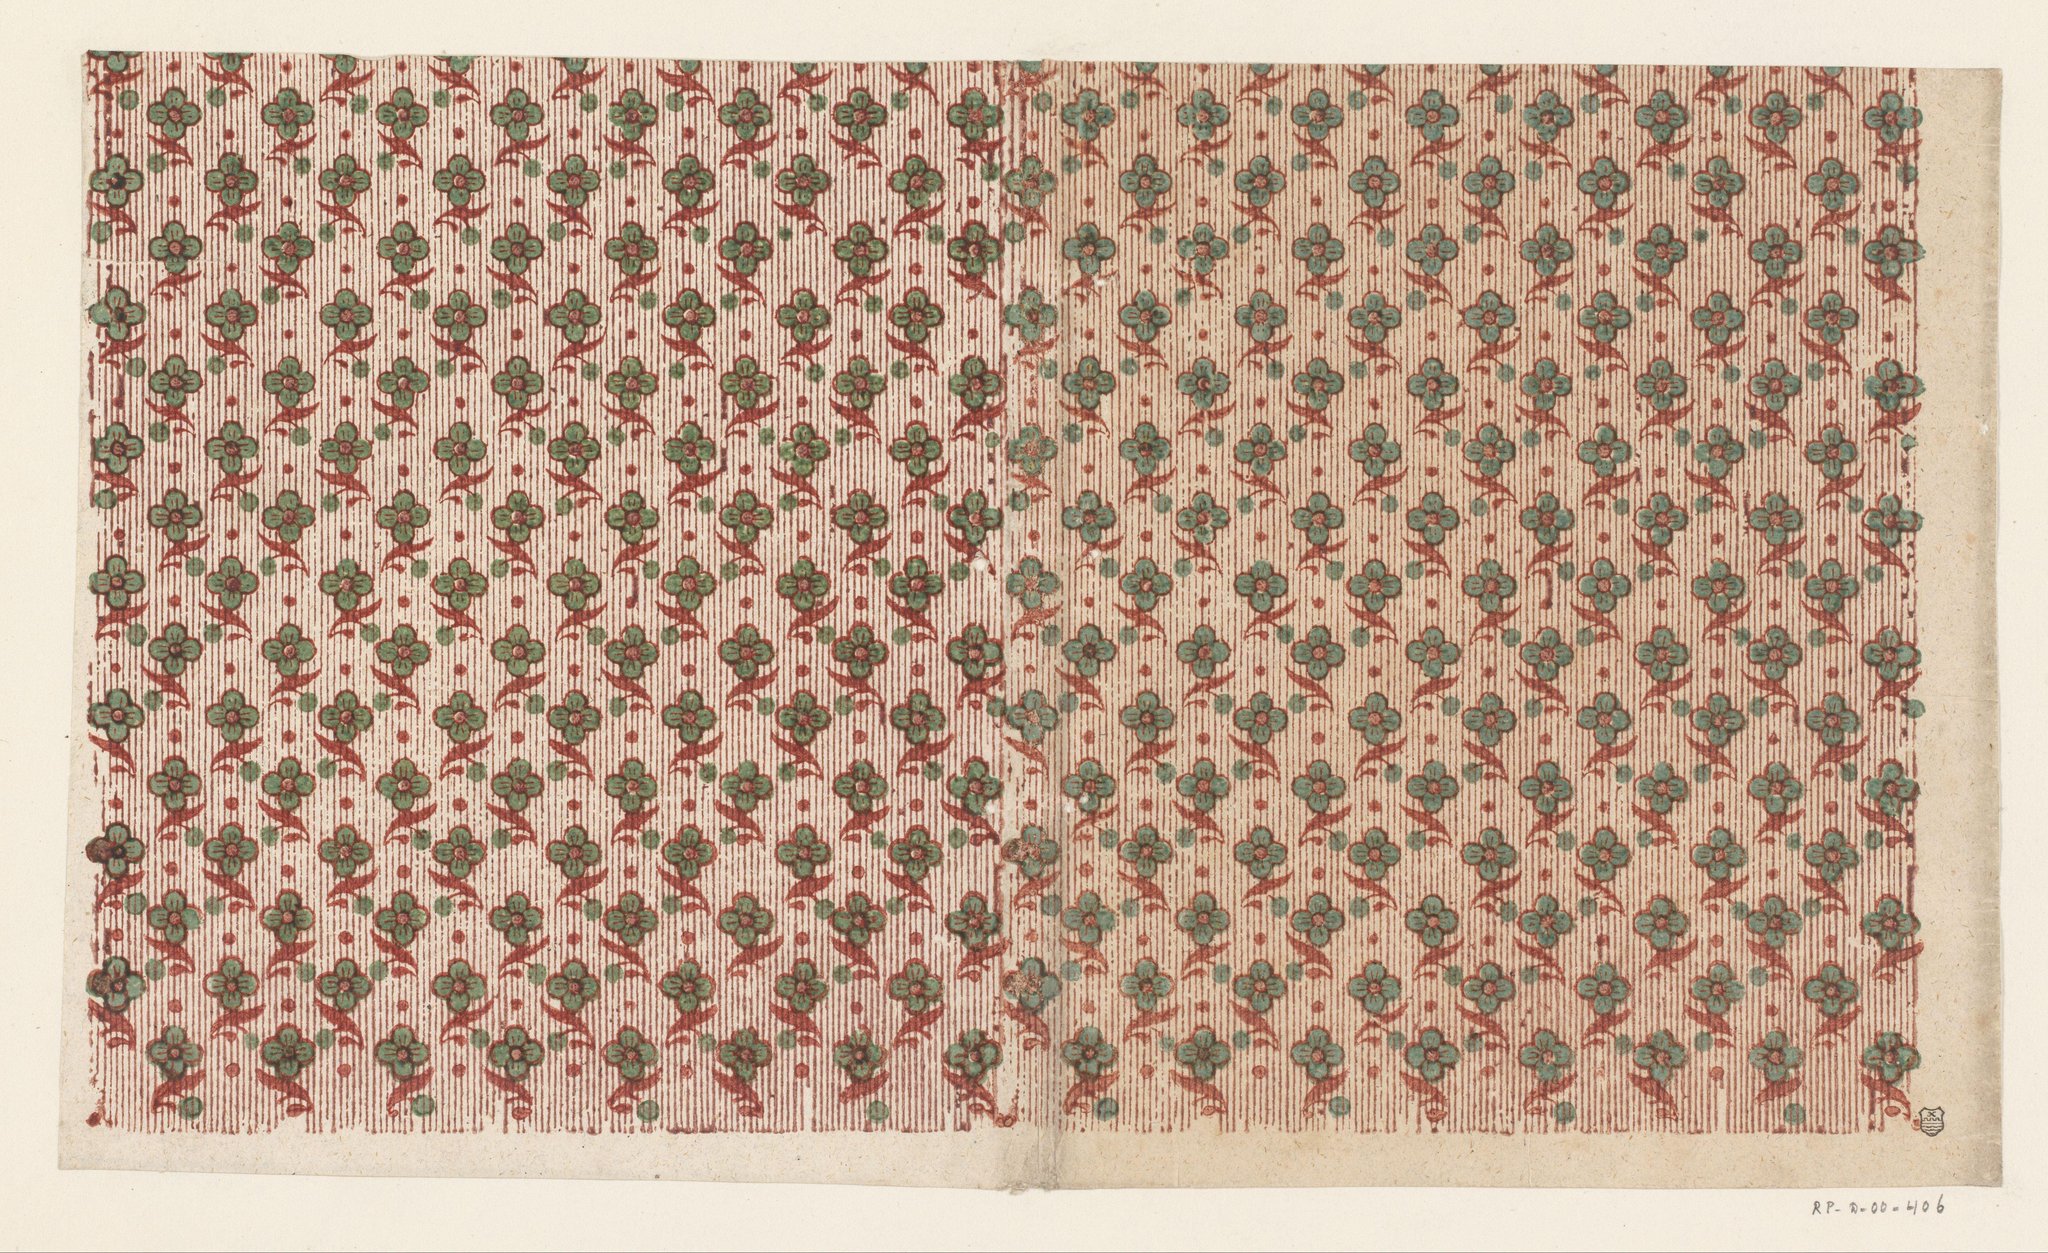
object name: printed paper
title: Blad met strooipatroon van bloem met een lijnenfond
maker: Anonymous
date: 1700-1850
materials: paper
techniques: printing block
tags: ornament derived from plant forms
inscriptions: collector's mark: Lugt 2760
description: Blad met strooipatroon van bloem met een verticaal lijnenfond. Gebruikt als omslag.